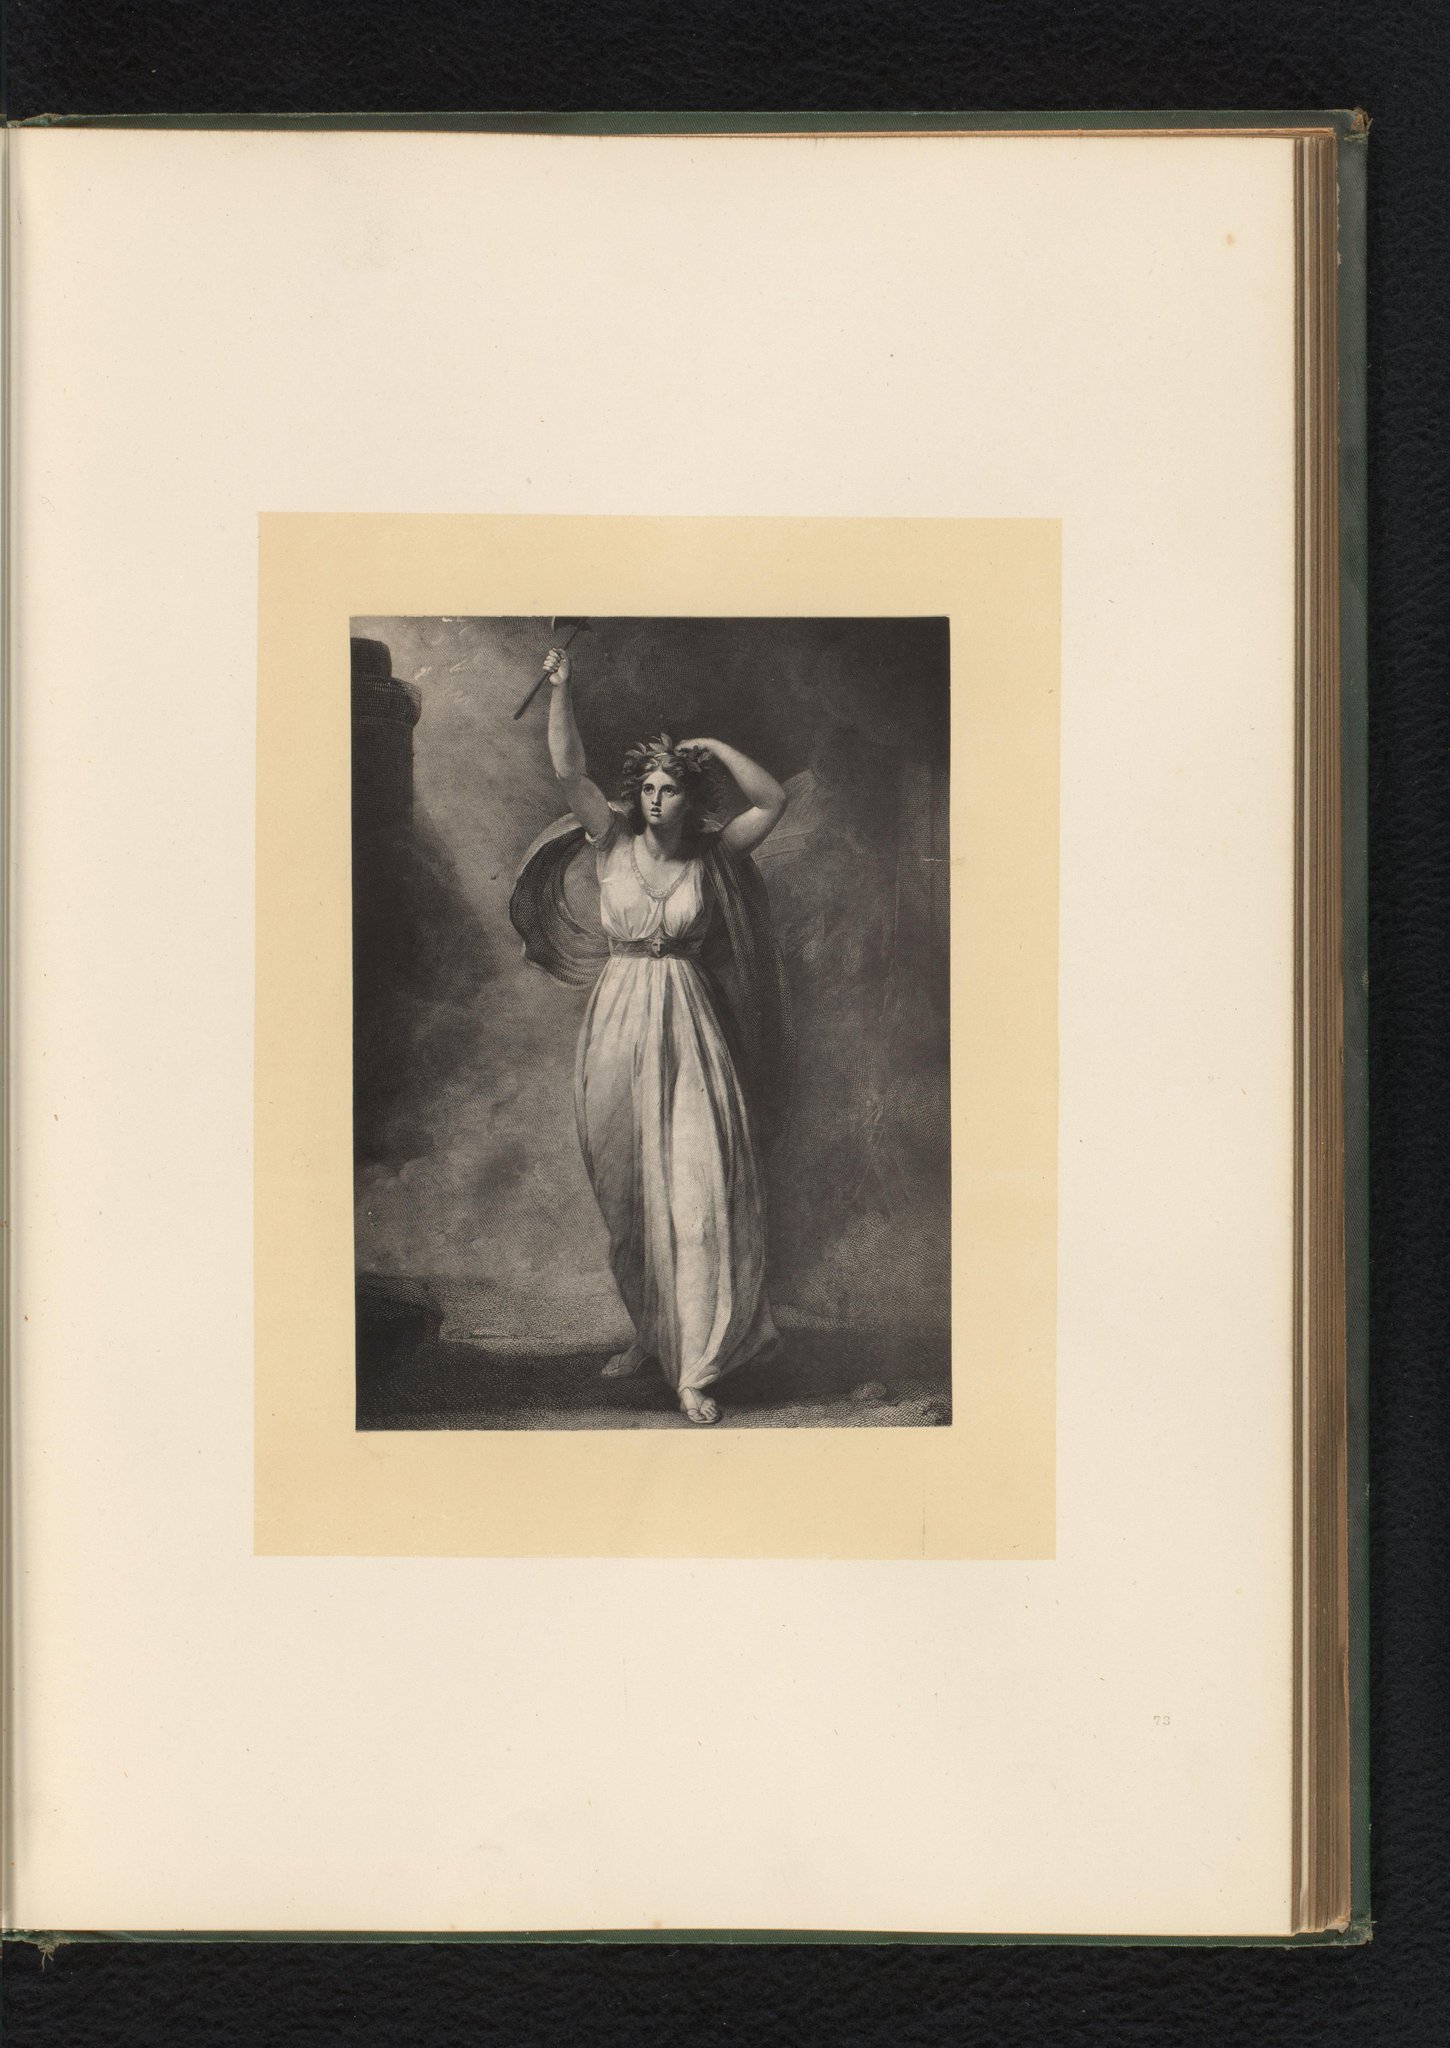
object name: page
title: Reproductie van een gravure naar een schilderij van een scène uit Troilus and Cressida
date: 1874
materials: paper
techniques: woodburytype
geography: london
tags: theatre, theatrical performance